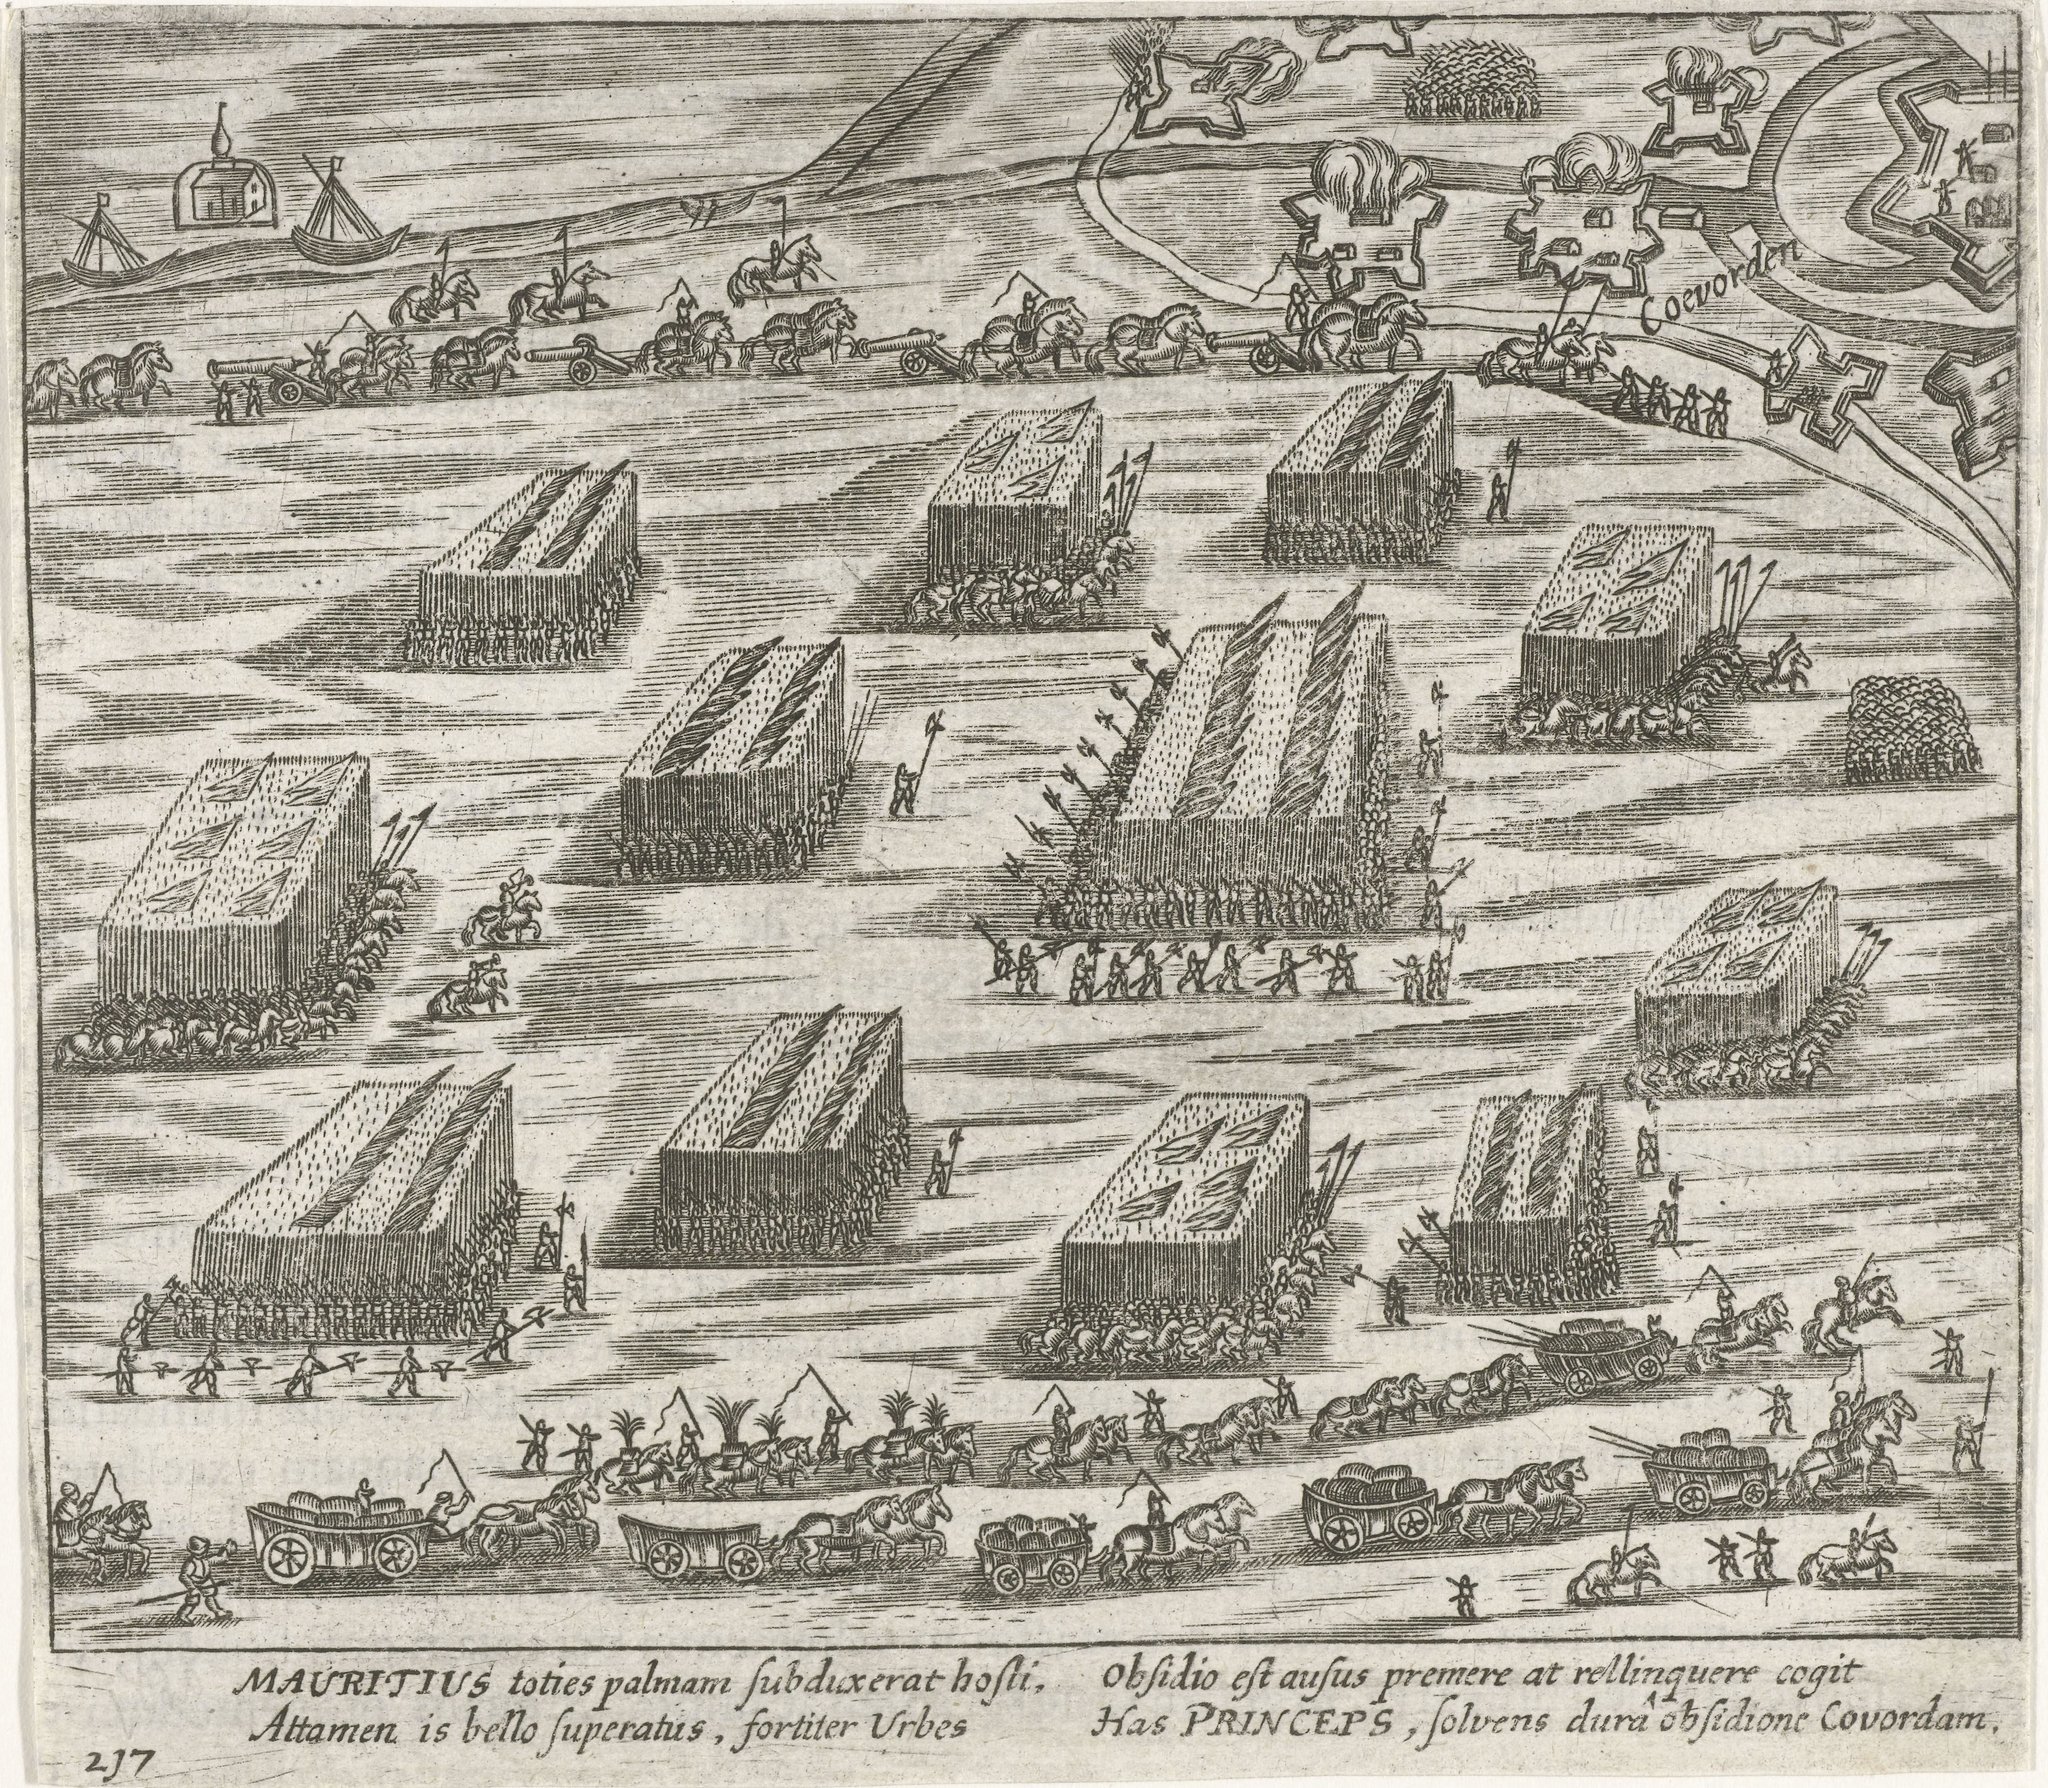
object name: print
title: Coevorden door Maurits ontzet, 1594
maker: Anonymous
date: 1613-1615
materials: paper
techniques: engraving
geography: northern netherlands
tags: maurice (prince of orange), troop movements, transportation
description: Coevorden, belegerd door Spaanse troepen onder Verdugo, wordt door het Staatse leger onder prins Maurits ontzet, 7 mei 1594. Het leger trekt in marsorde op naar Coevorden. Met onderschrift van 4 regels in het Latijn. Genummerd 217. Bedrukt op achterzijde met tekst in het Latijn.